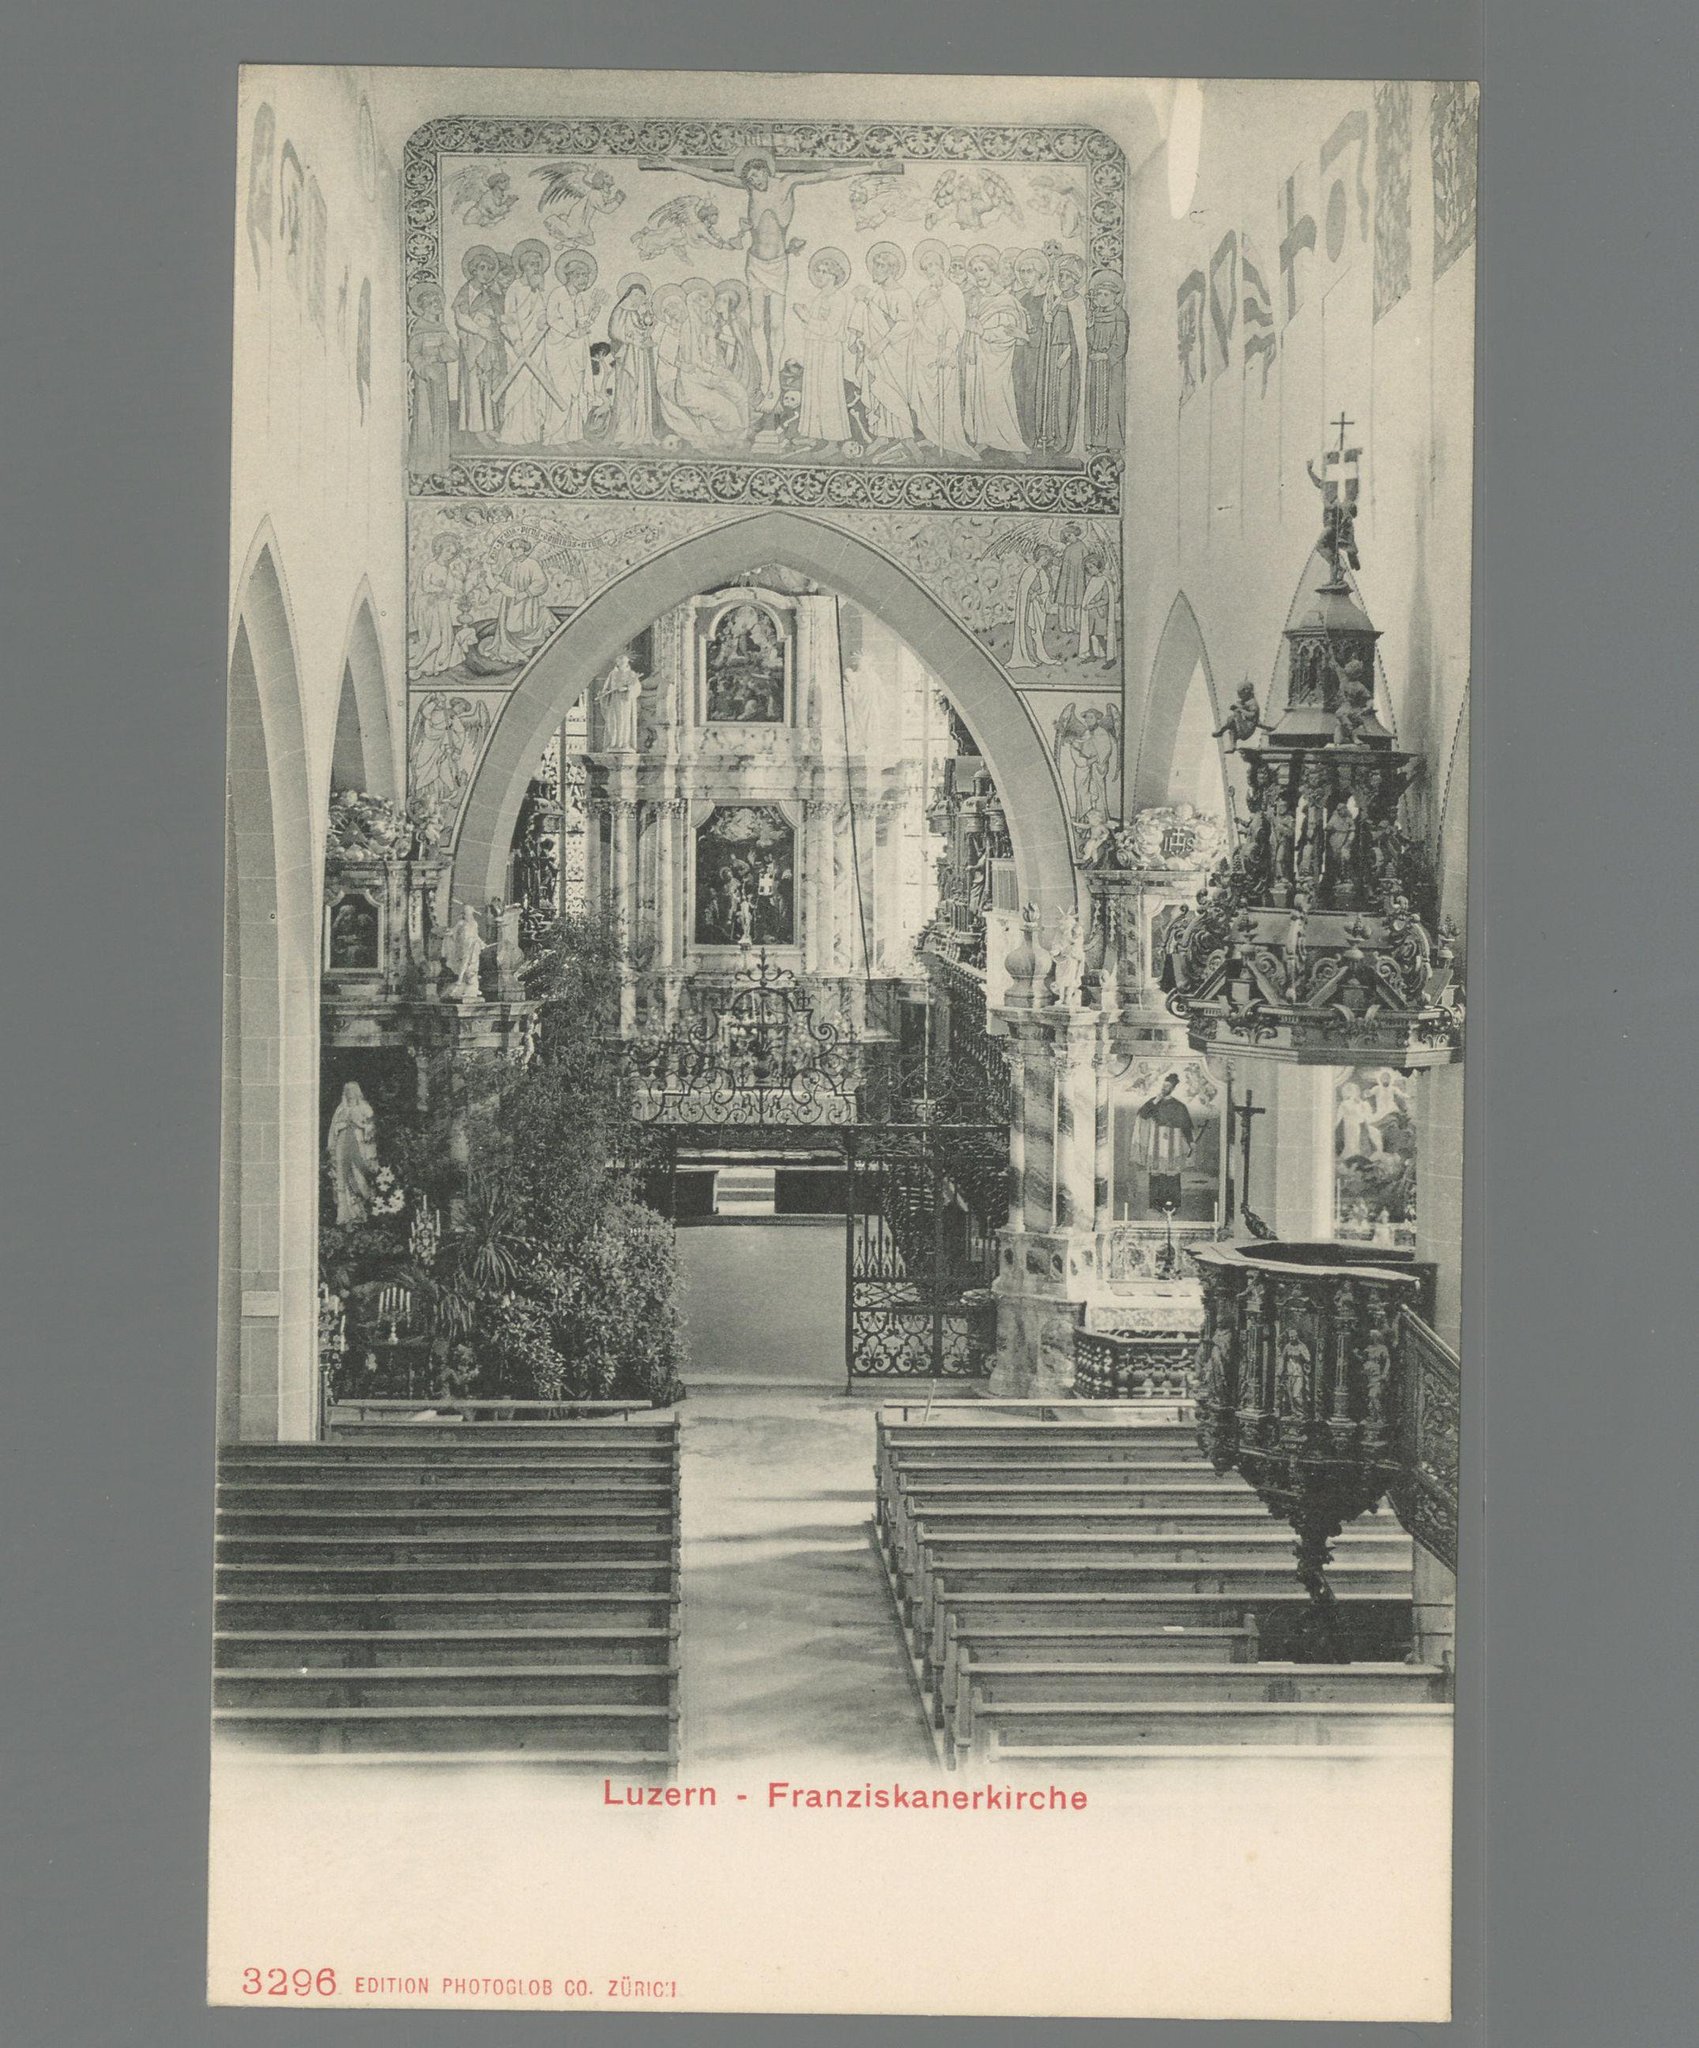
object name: ansichtkaart, prentbriefkaart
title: Luzern. Franziskanerkirche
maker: Anonymous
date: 1895-1905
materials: cardboard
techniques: photograph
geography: zurich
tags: interior of church